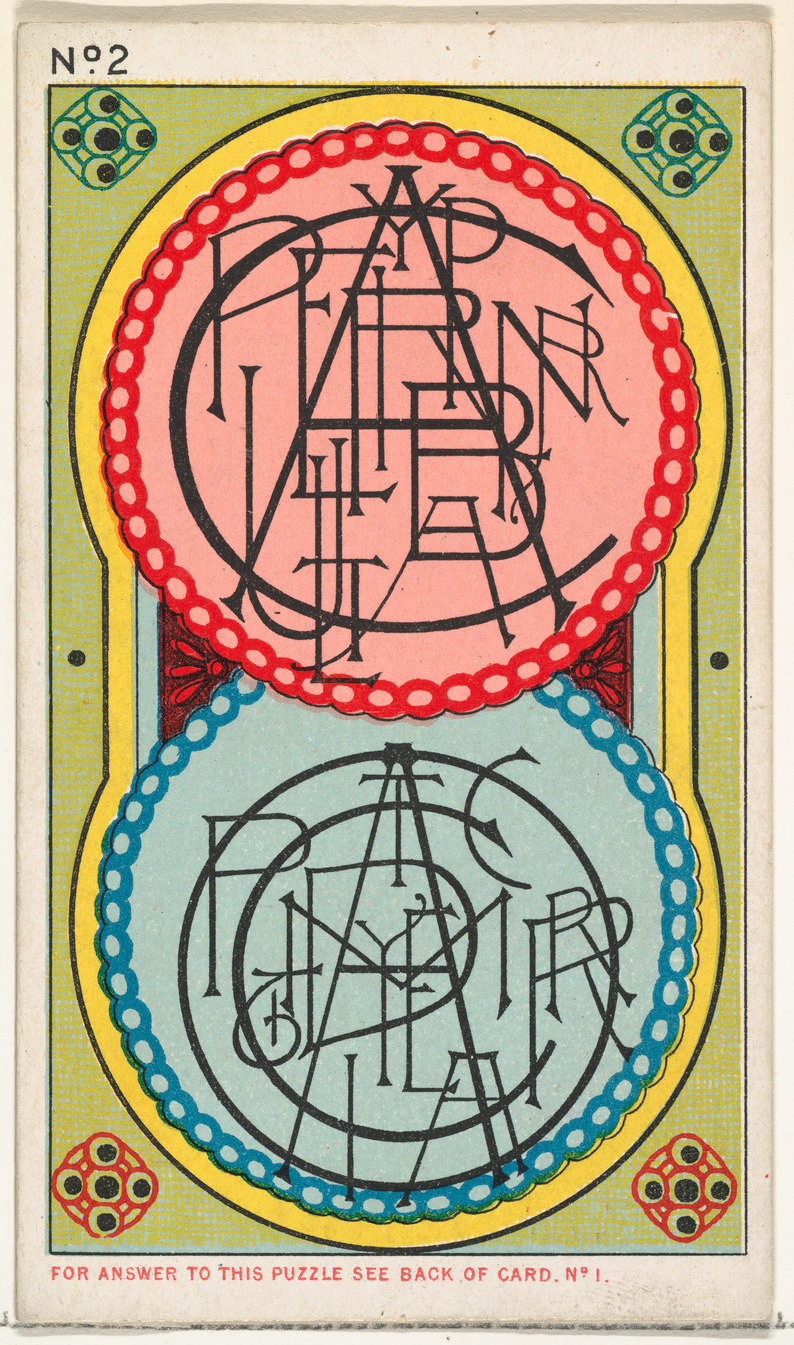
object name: print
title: Puzzle Card Number 2, from the Jokes series (N118) issued by Duke Sons & Co. to promote Honest Long Cut Tobacco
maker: w. duke, sons & co.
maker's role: publisher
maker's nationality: american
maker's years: 1870-1920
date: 1890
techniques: color lithograph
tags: games